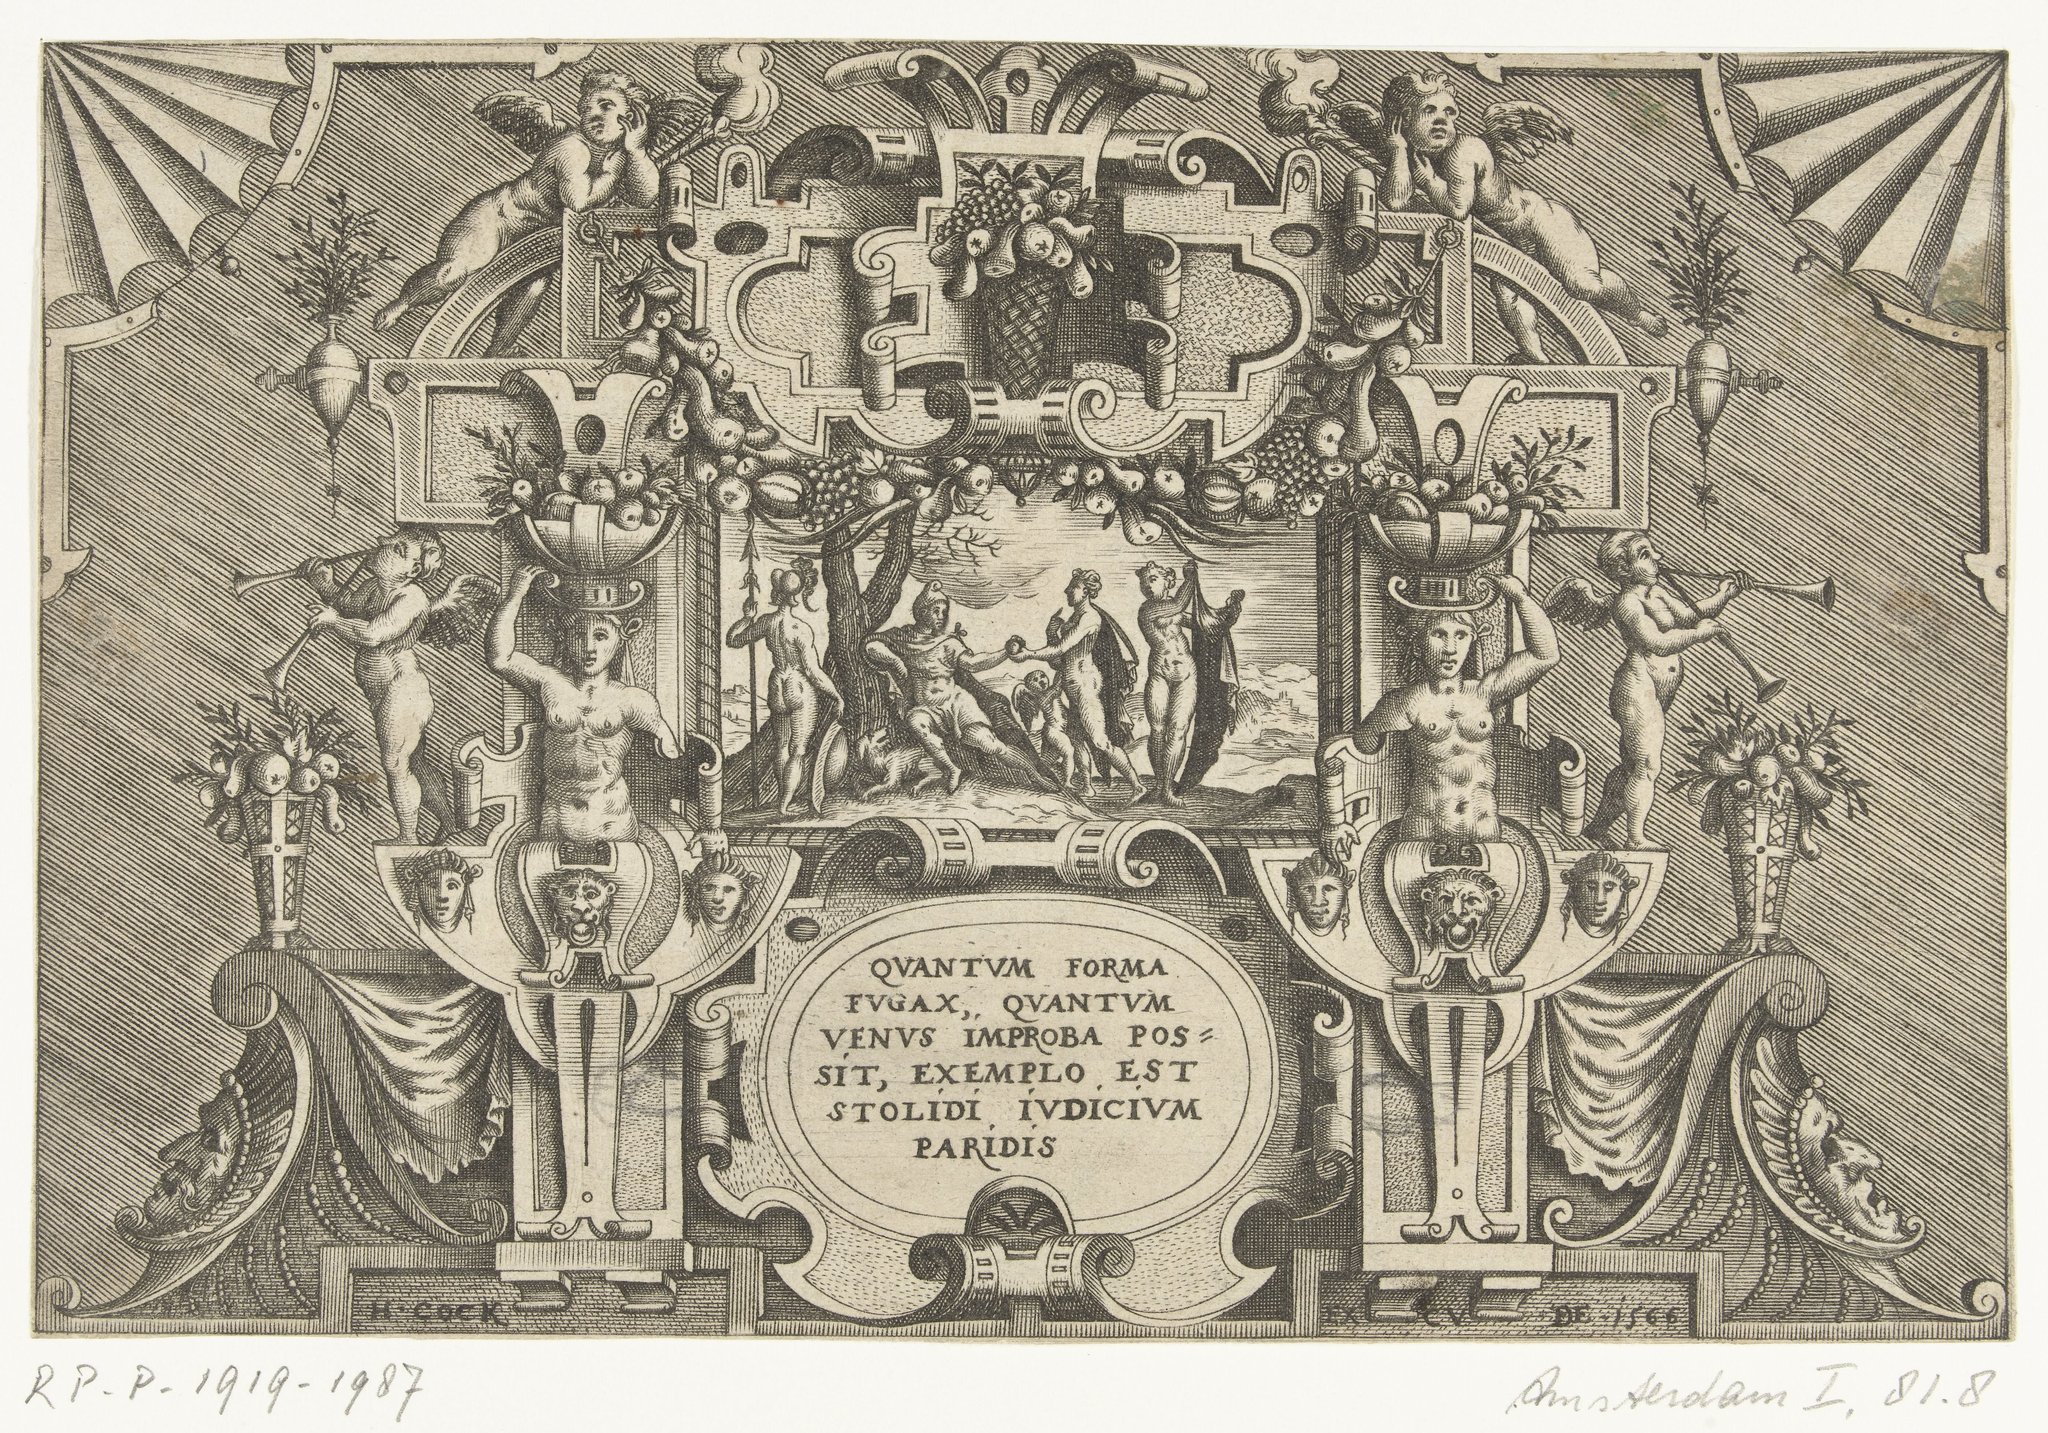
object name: ornament print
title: QVANTVM FORMA/ FVGAX, QVANTVM/ VENVS IMPROBA POS (...)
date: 1566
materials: paper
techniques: engraving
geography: netherlands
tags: the judgement of paris (without mercury)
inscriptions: date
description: Het oordeel van Paris in een omlijsting van rolwerk met vrouwelijke hermen, mascarons, putti en guirlandes. Blad uit serie bestaande uit een titelblad en 15 van de 16 bladen met cartouches met bijbelse en mythologische voorstellingen in een omlijsting van rolwerk en grotesken.